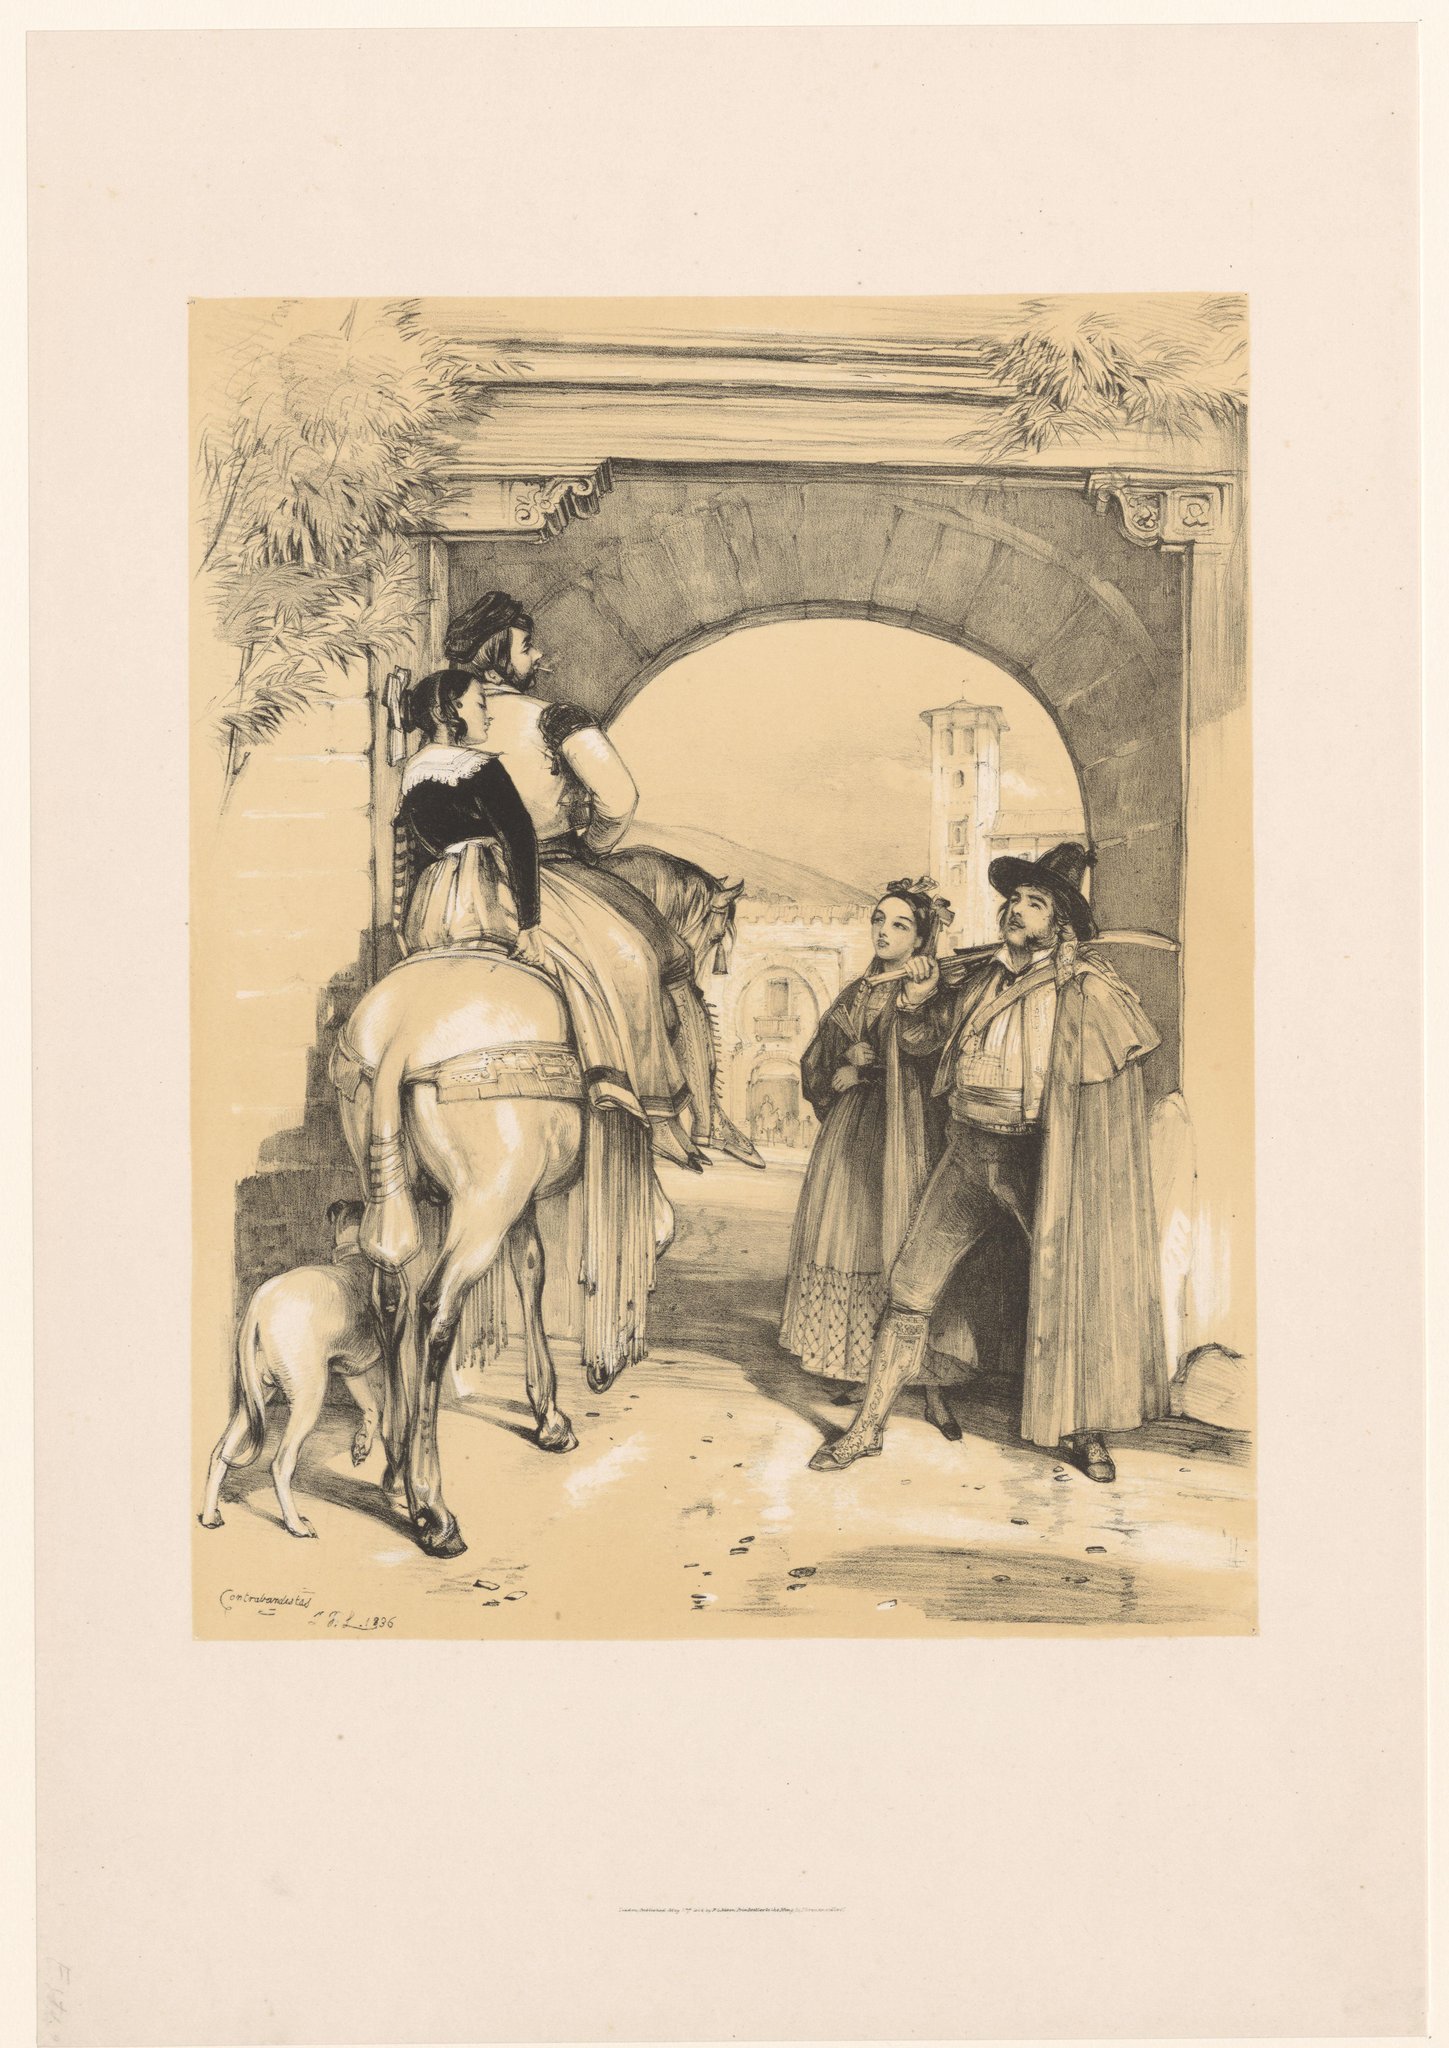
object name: print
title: Contrabandistas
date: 1836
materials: paper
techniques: tone lithography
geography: london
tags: riding a horse, ass, or mule; rider, horseman, gate, entrance, smuggler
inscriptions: collector's mark: Lugt 2228